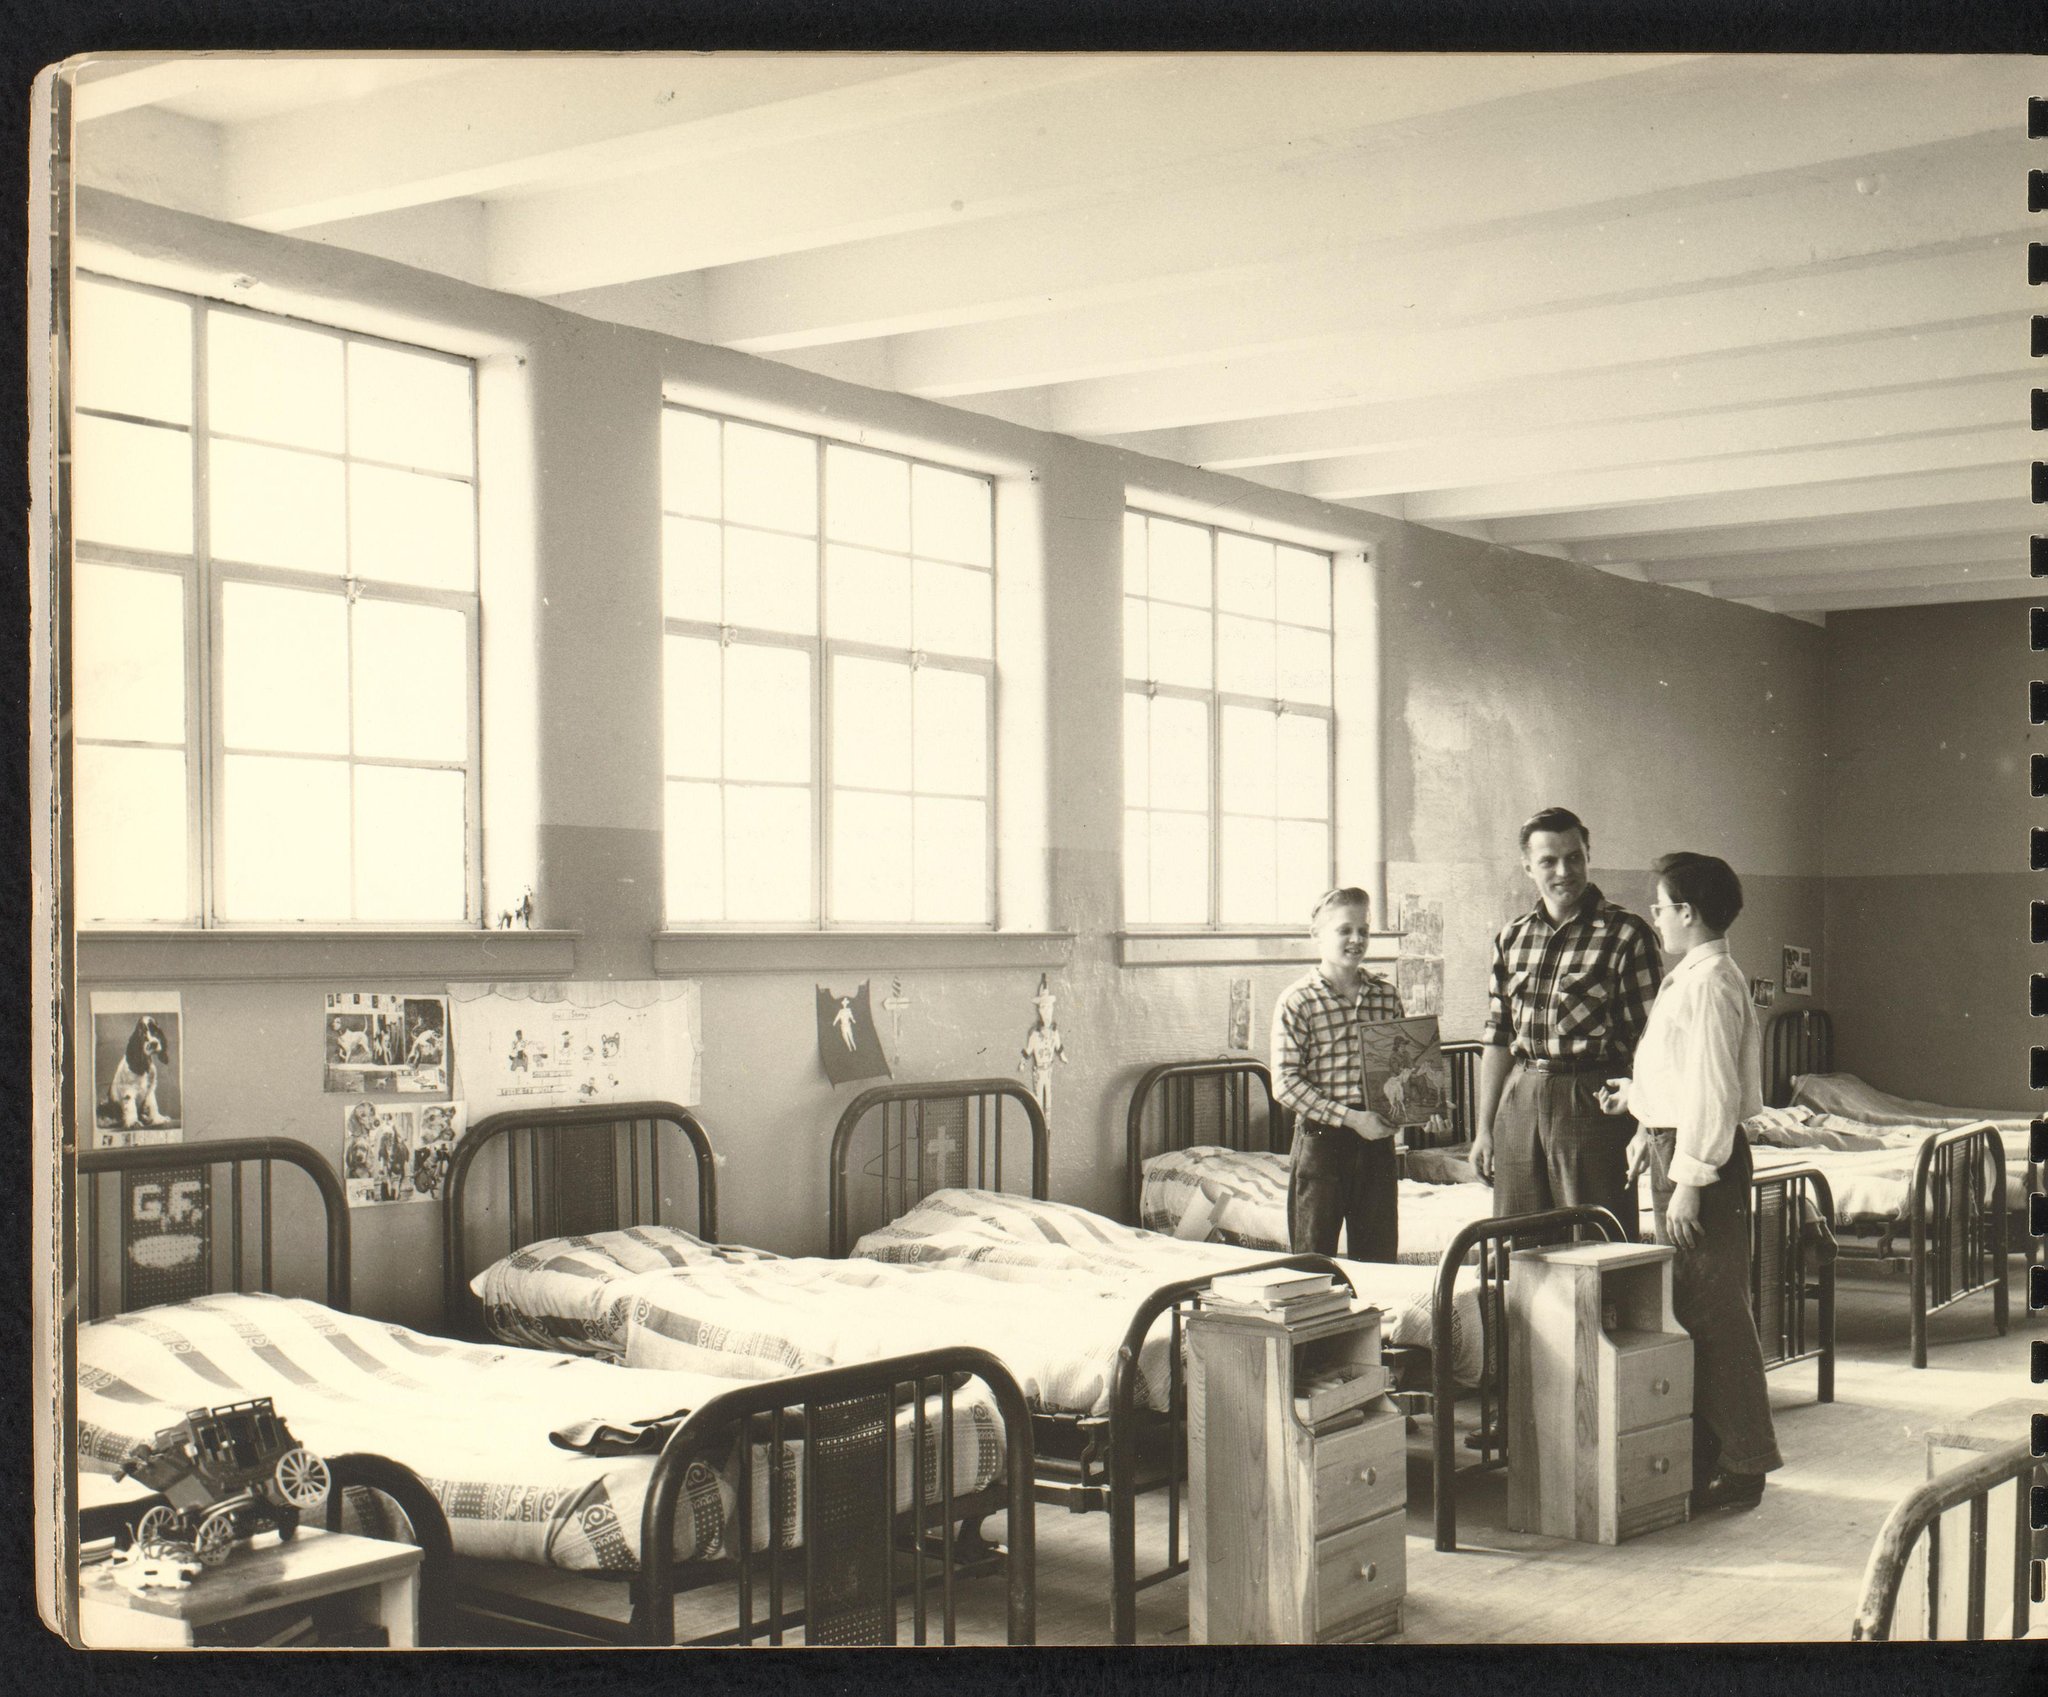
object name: photograph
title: Slaapzaal in de White Cottage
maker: Anonymous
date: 1950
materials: paper, photographic support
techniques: gelatin silver print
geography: new york city